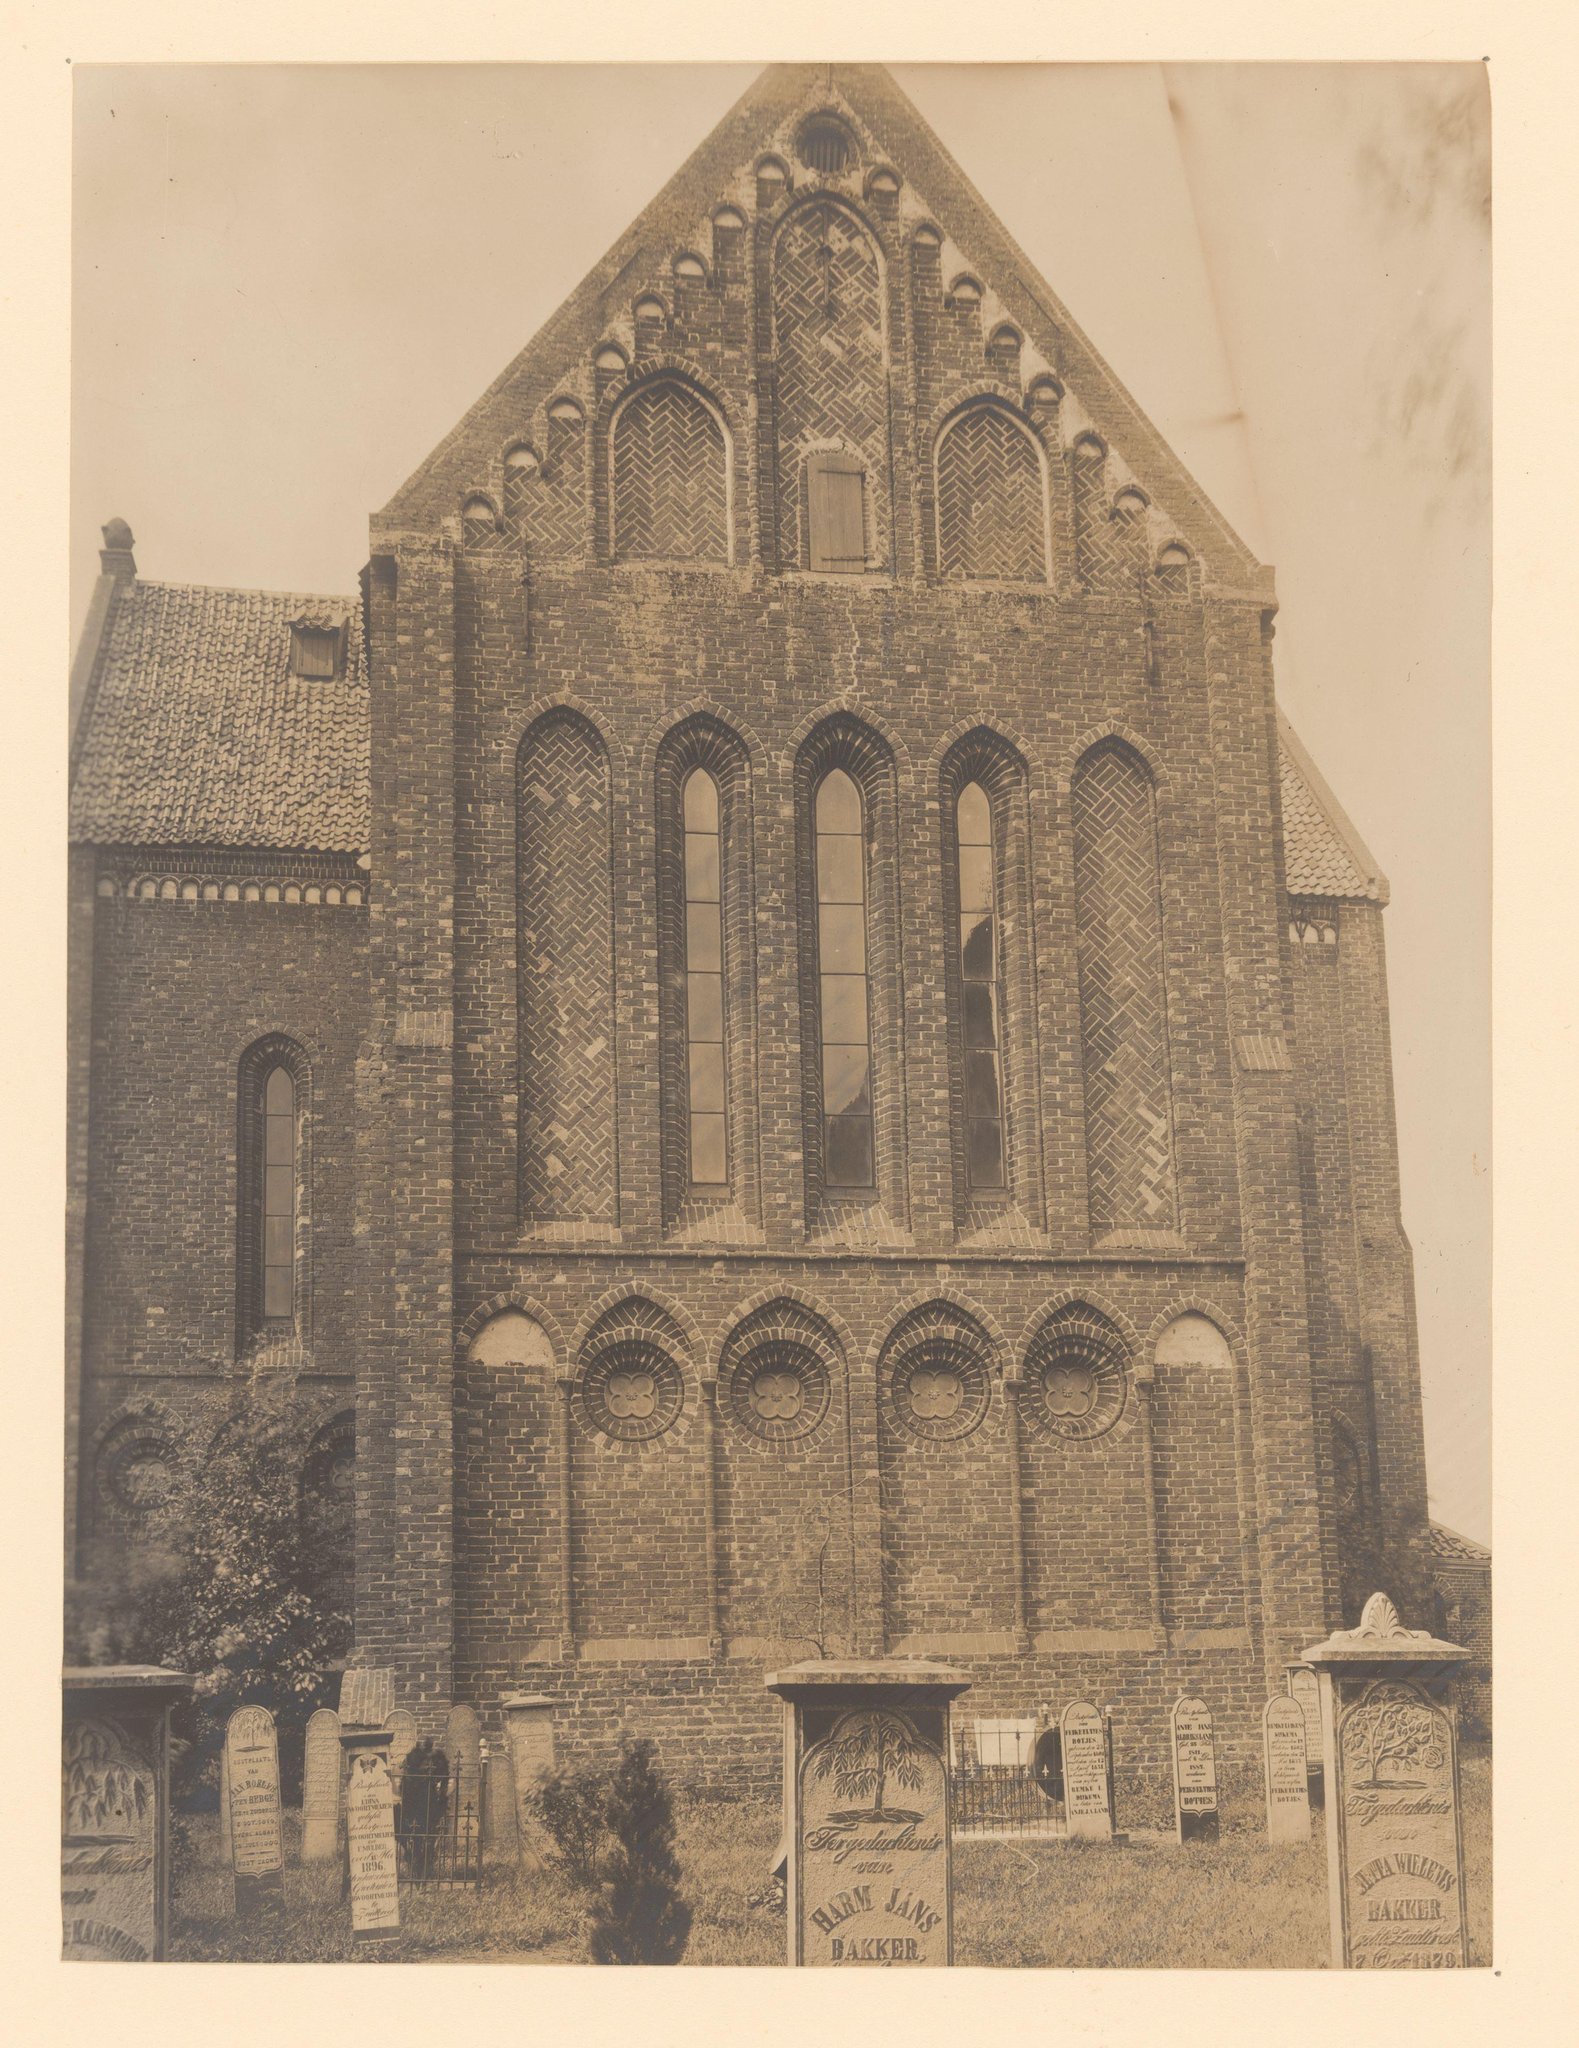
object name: photograph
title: Oostzijde van de Petruskerk te Zuidbroek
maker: anoniem (monumentenzorg)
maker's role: fotograaf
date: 1907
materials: cardboard, photographic support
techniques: gelatin silver print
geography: zuidbroek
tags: church (exterior), gravestone, tombstone, churchyard, cemetery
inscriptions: annotation: ‘Zuidbroek/ N.H. kerk (oostzijde/ Juli 1907’, annotation: ‘Zuidbroek’